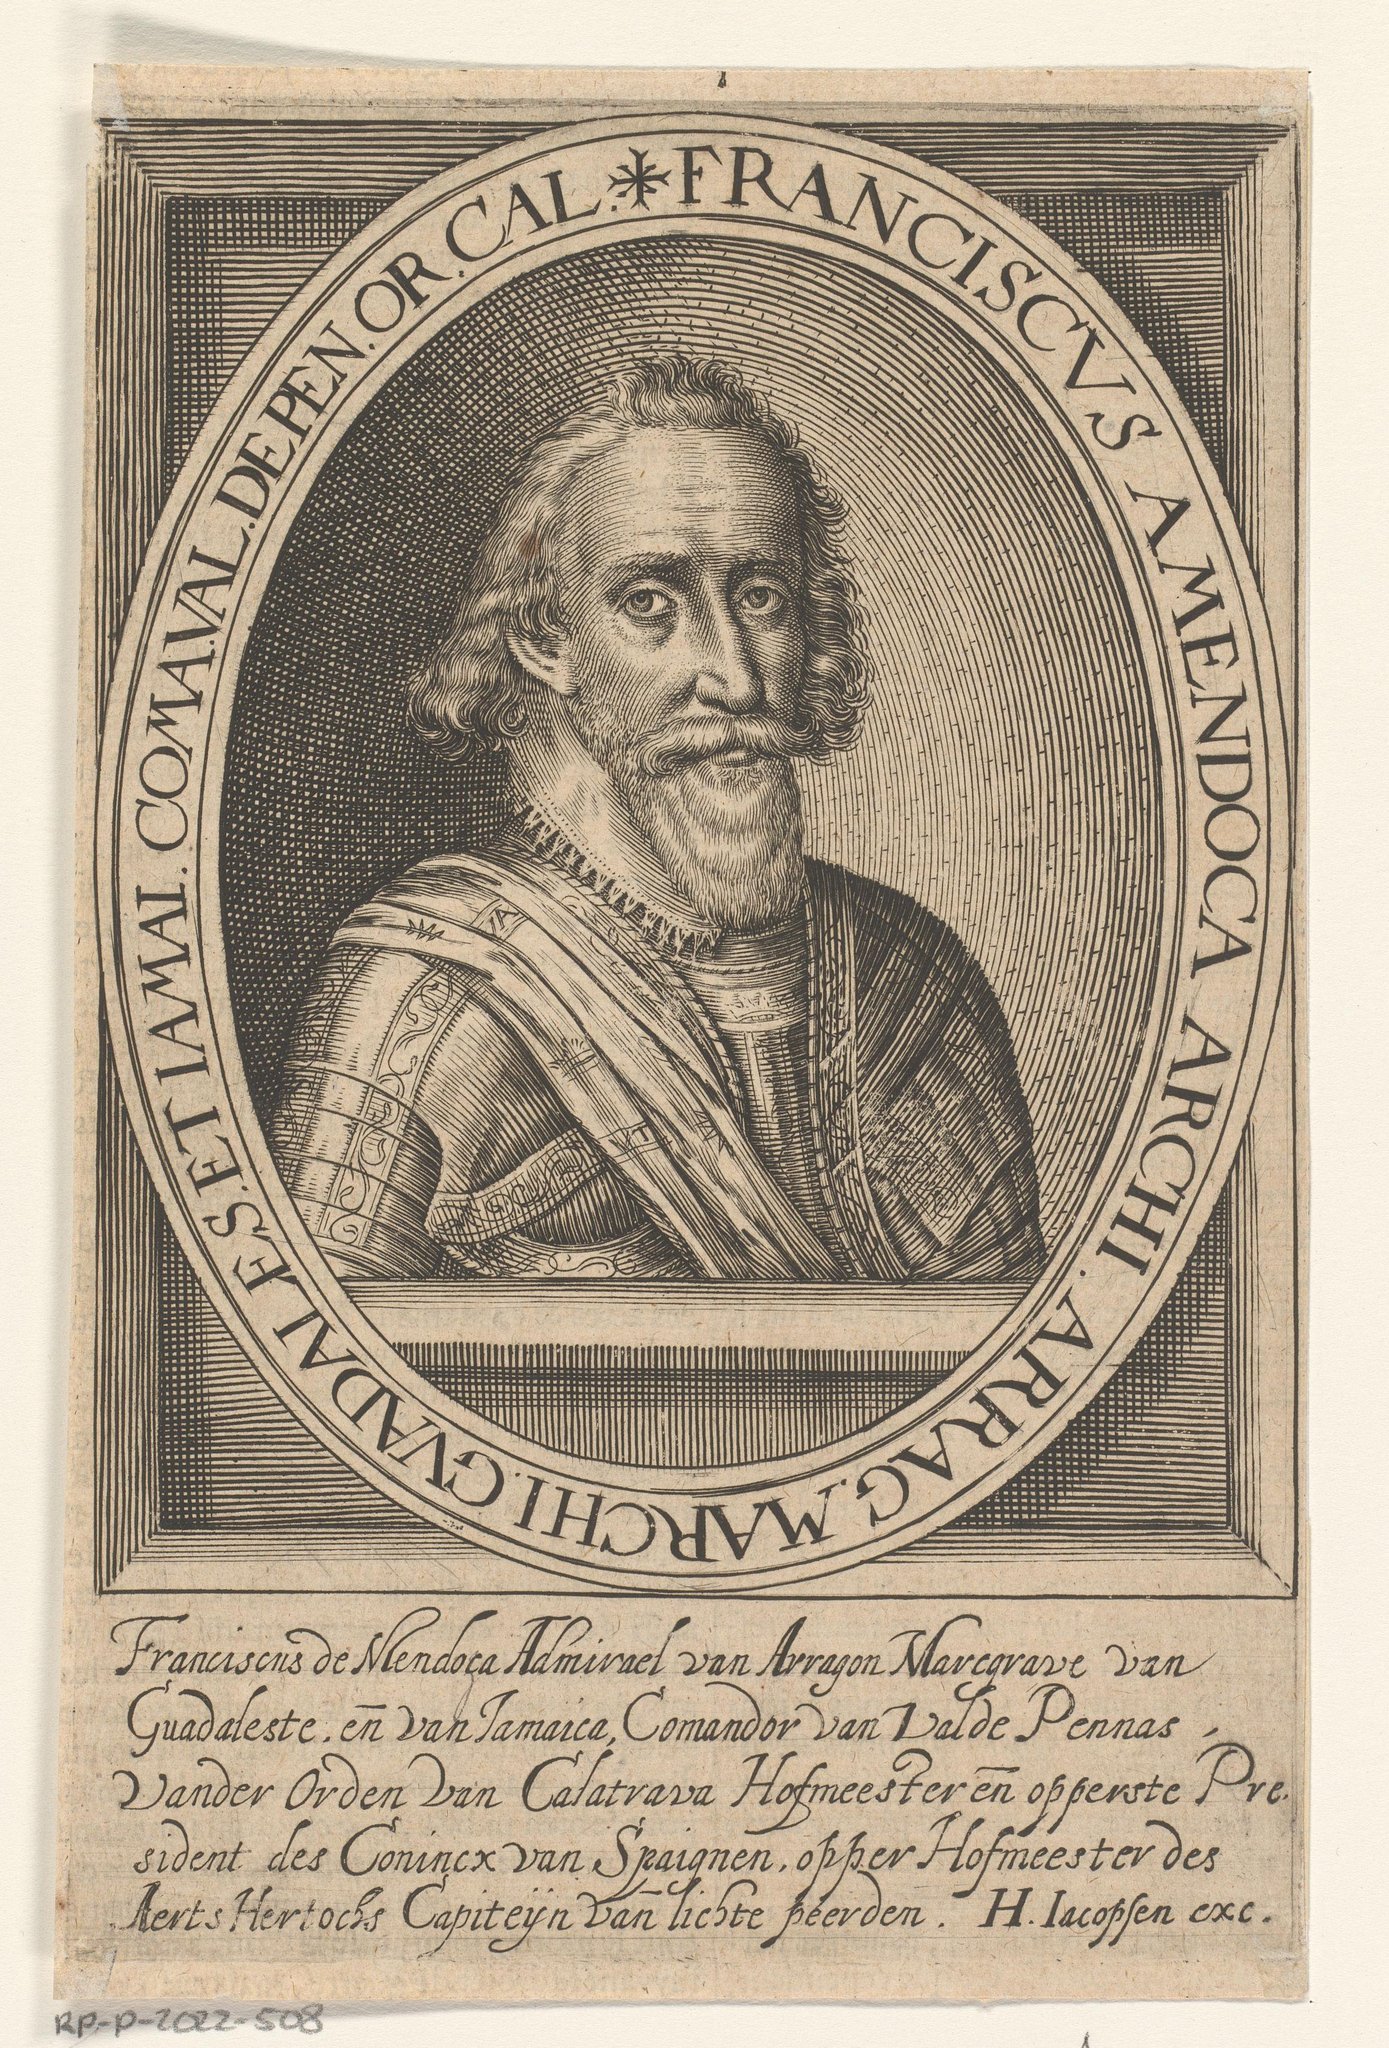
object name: print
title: Portret van Francisco Hurtado de Mendoza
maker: h. jacopsen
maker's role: publisher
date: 1595-1800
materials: paper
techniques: engraving, letterpress printing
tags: commander-in-chief, general, marshal, historical persons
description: Met vijfregelig onderschrift in het Nederlands.